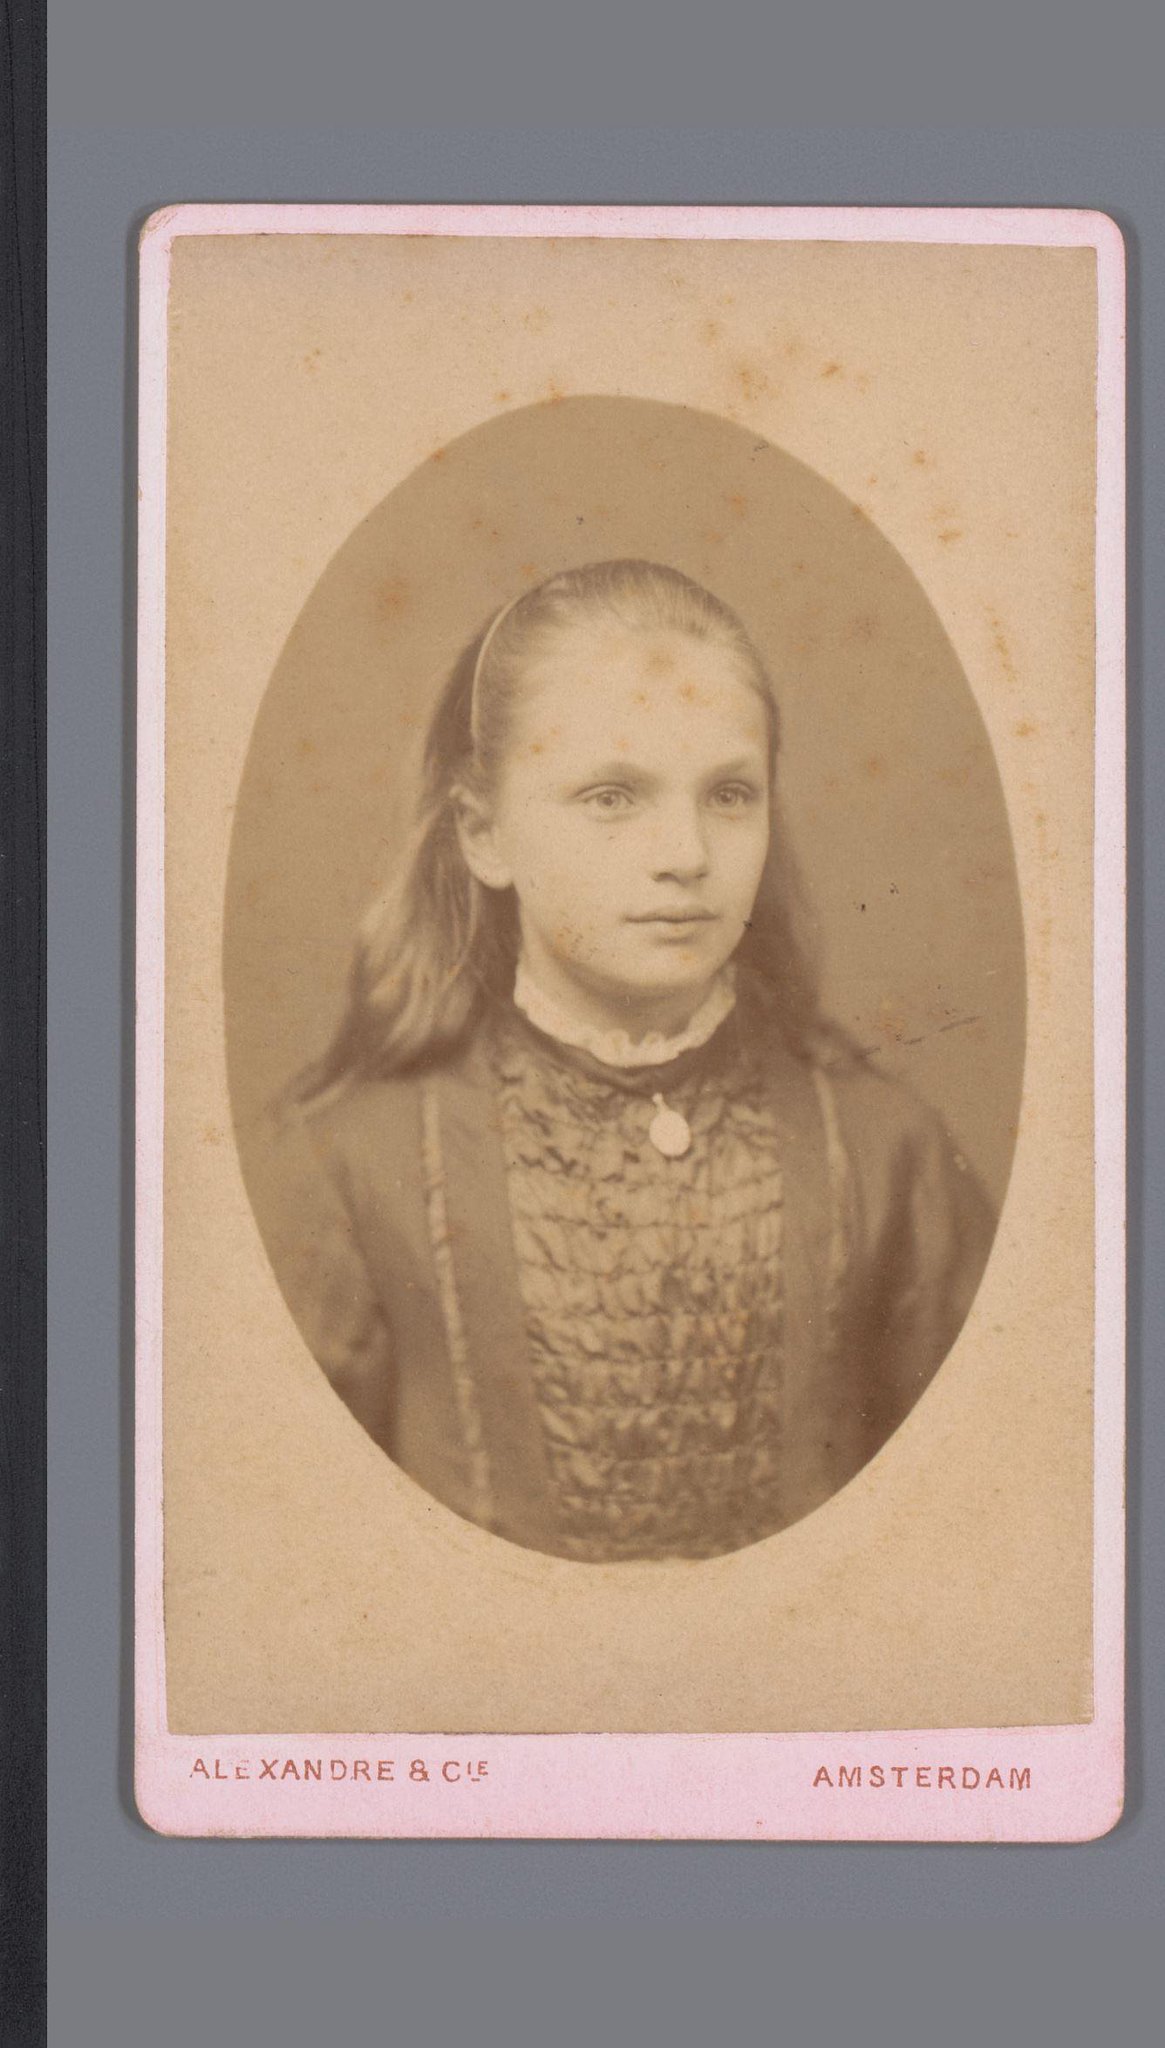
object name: photograph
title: Portret van Jacqueline E. van der Waals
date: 1876-1900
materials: cardboard, photographic support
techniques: albumen print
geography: amsterdam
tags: the hague, historical persons, amsterdam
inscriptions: workshop stamp: ‘Photographie Belge/ Alexandre & Cie/ 162, Kalverstraat, Amsterdam’